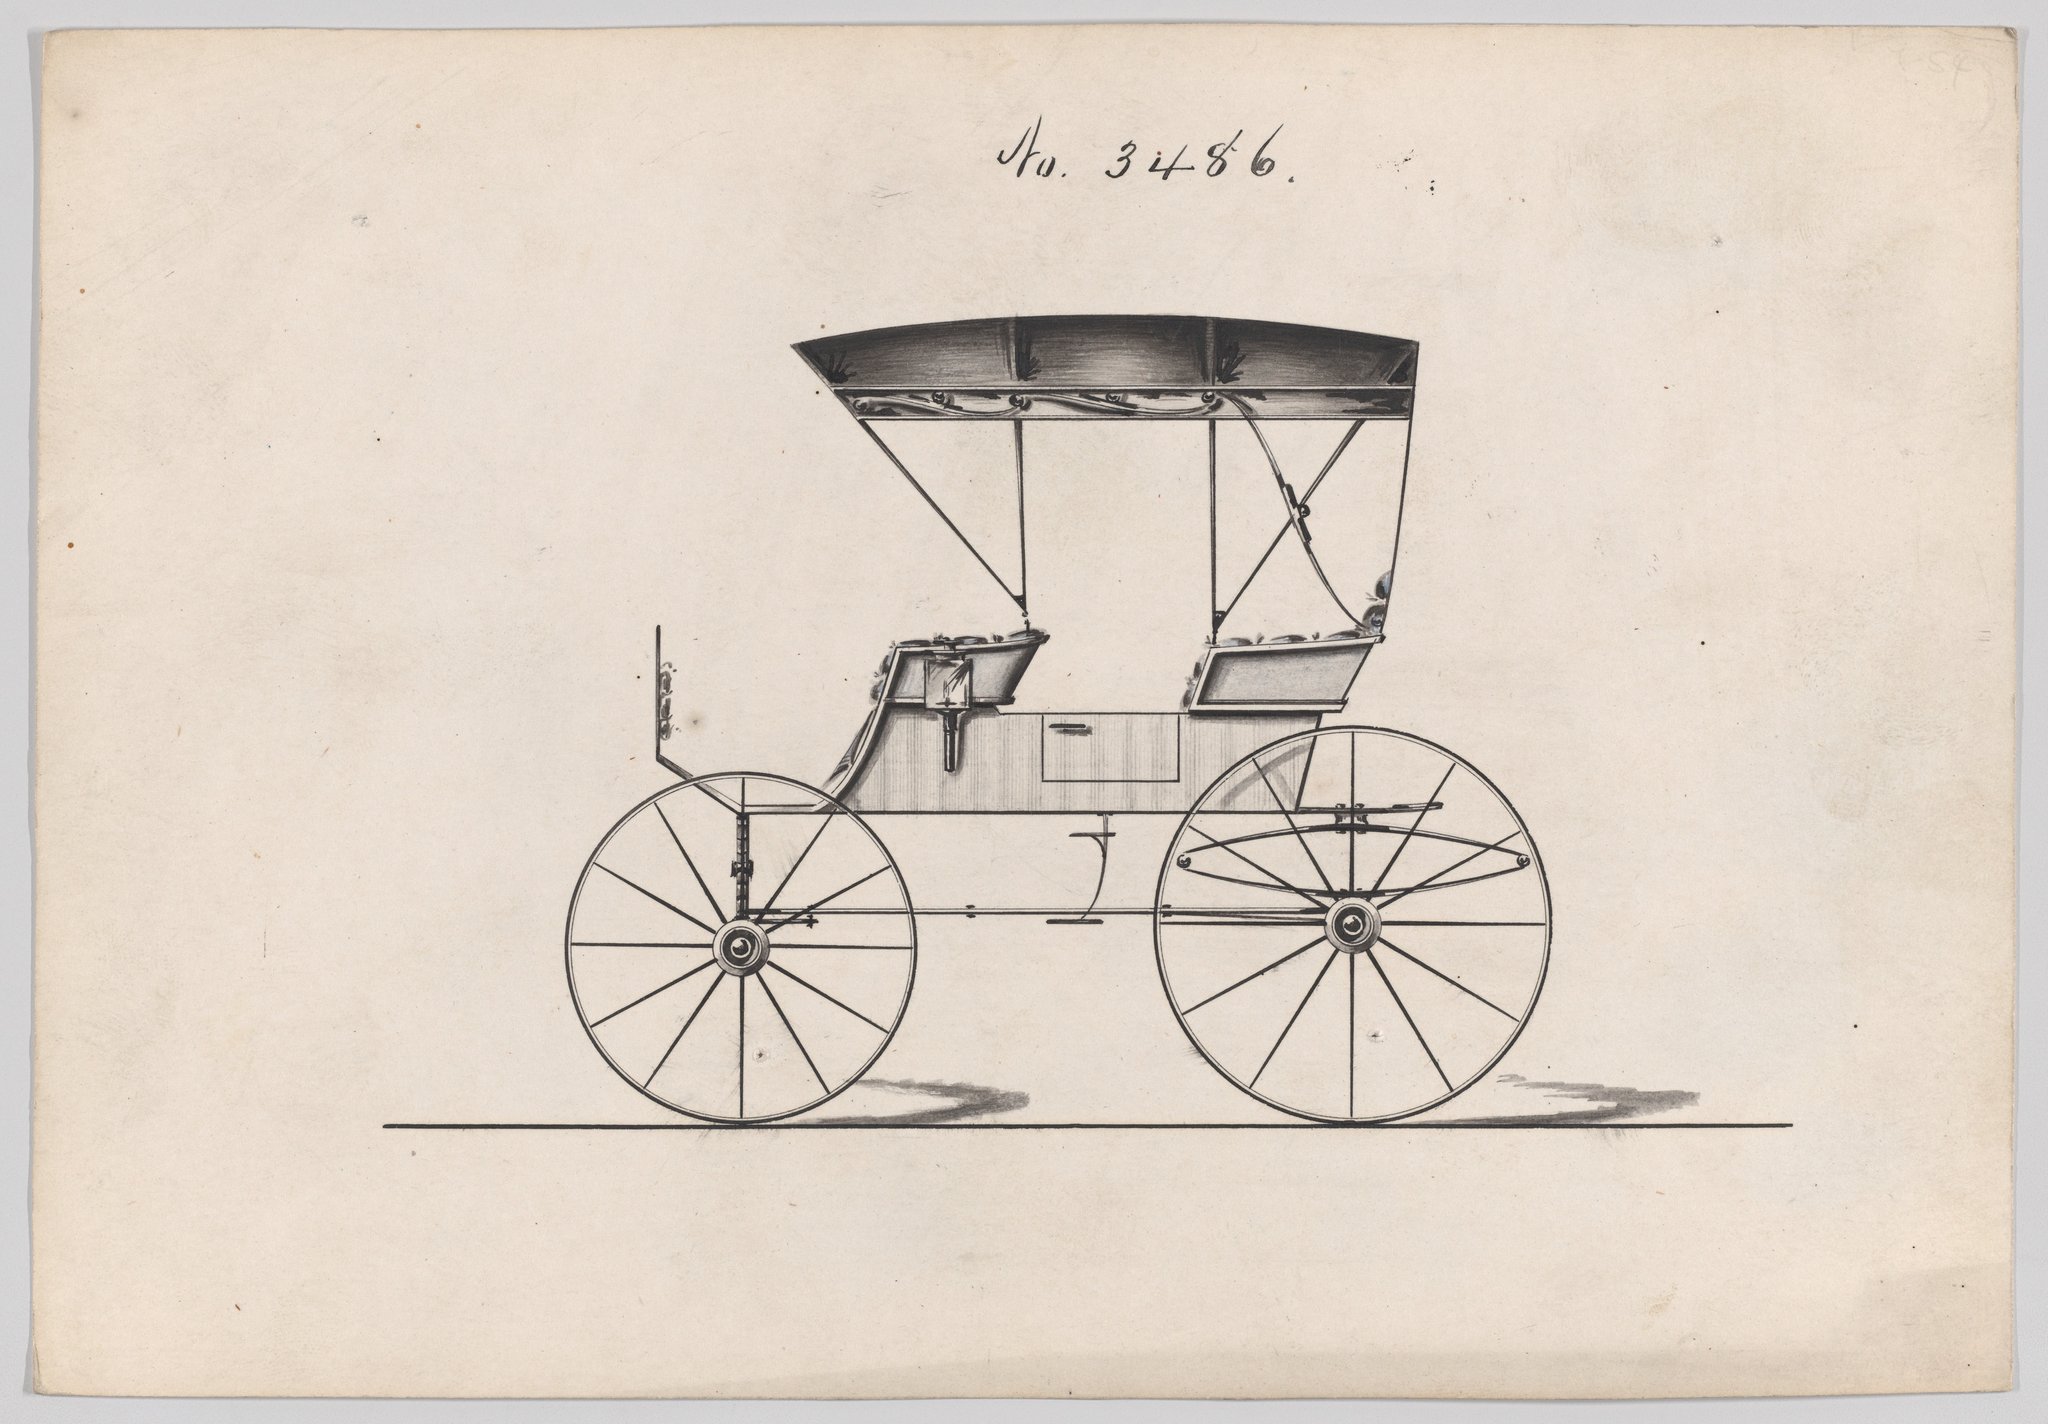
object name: drawing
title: Design for Extension Top Park Phaeton, no. 3486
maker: brewster & co.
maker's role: manufacturer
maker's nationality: american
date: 1879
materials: ink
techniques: pen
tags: carriages